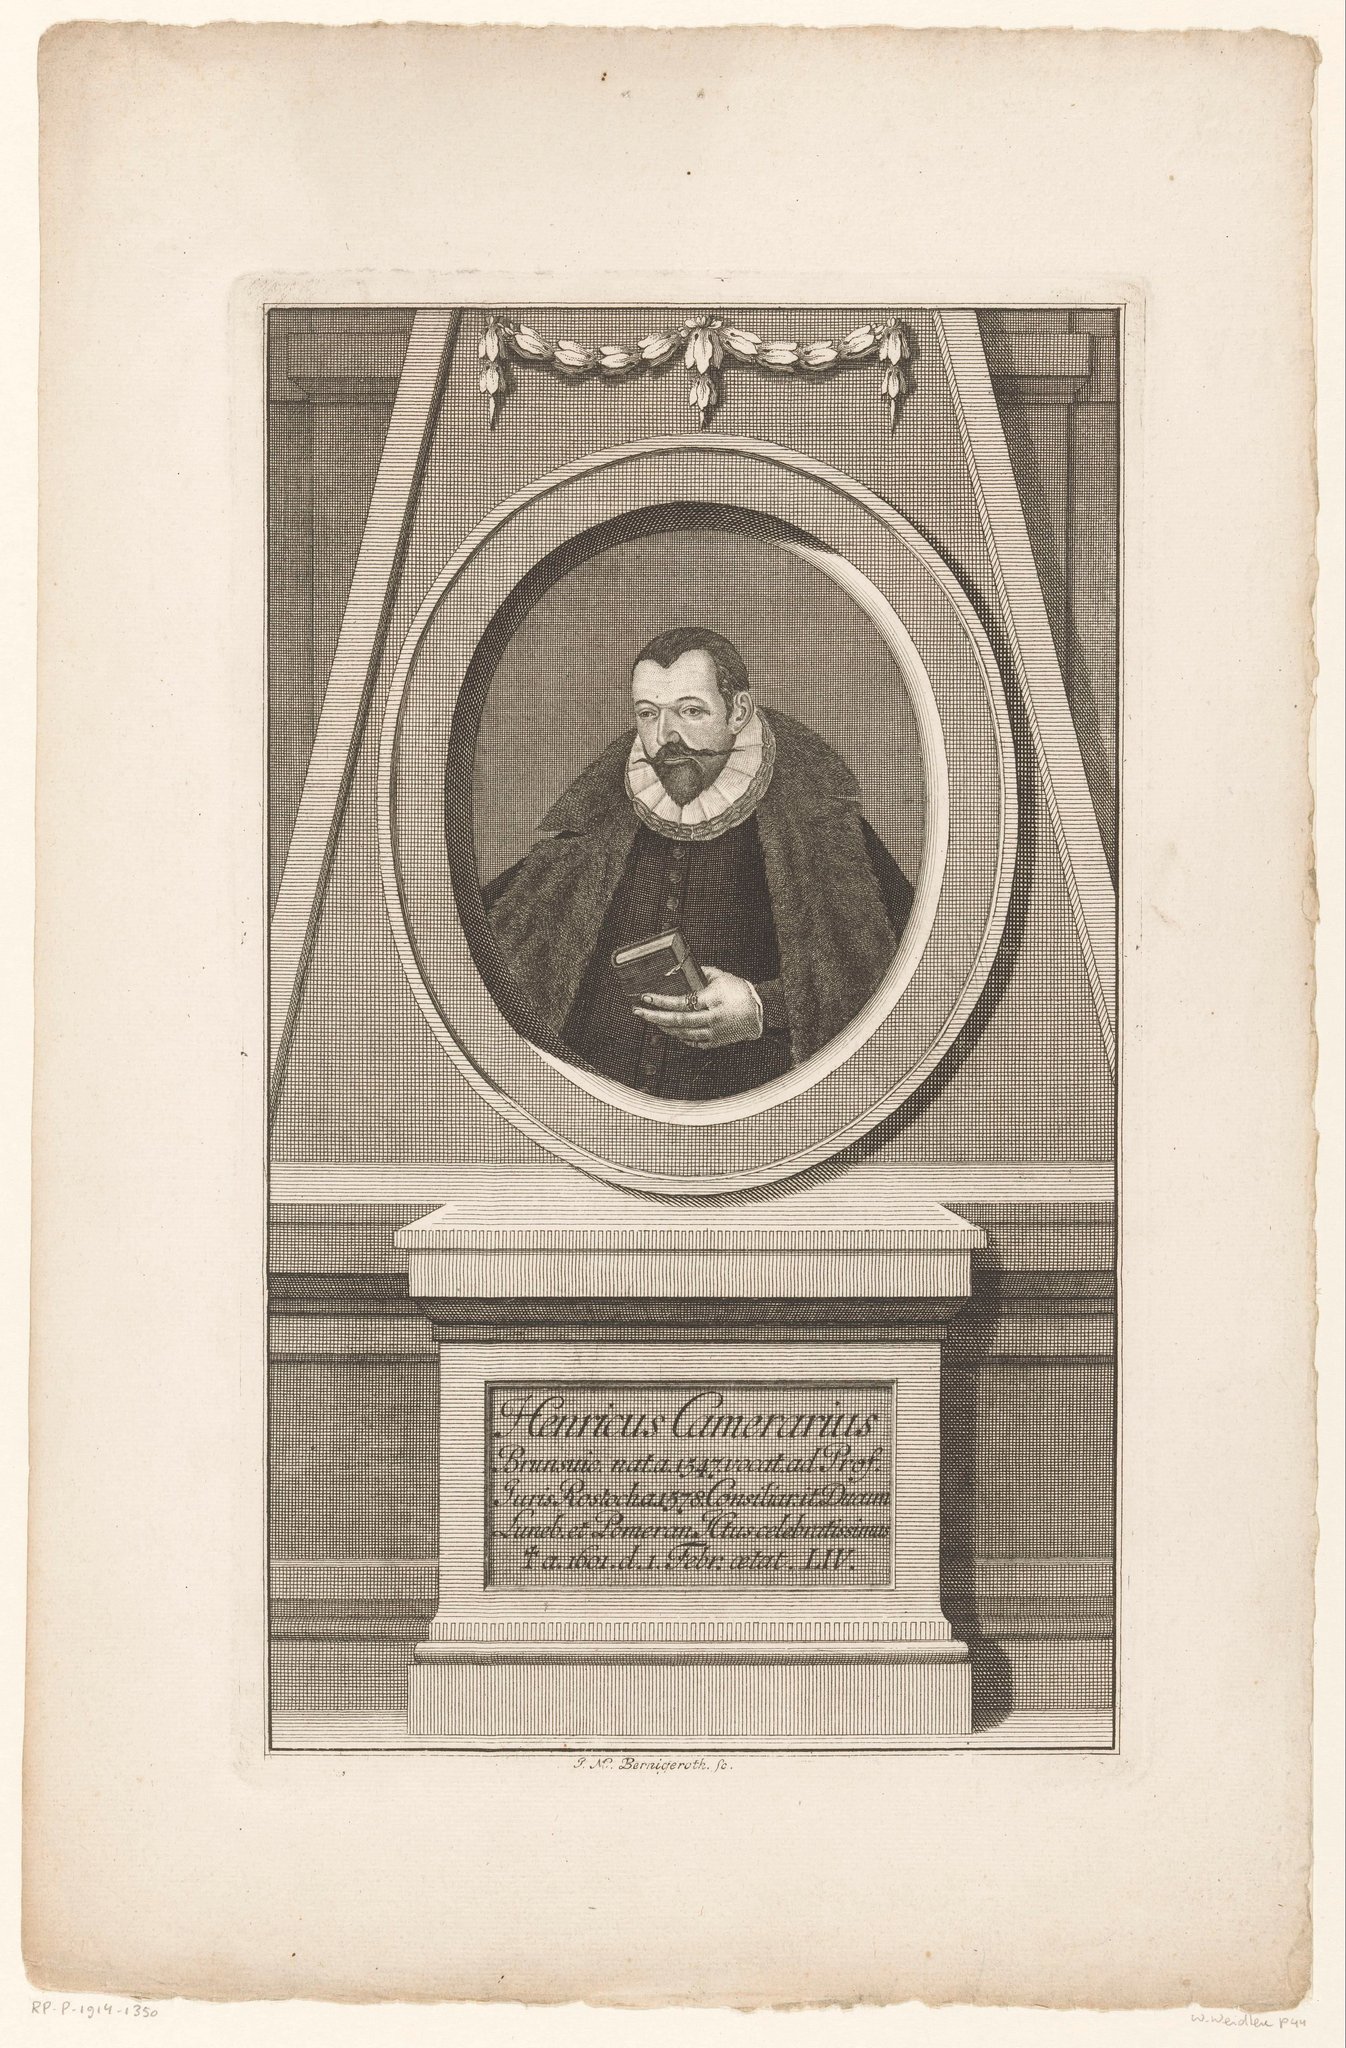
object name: print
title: Portret van Heinrich Camerarius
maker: johann martin bernigeroth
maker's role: print maker, publisher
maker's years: 1713-1767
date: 1743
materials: paper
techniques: engraving, etching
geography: leipzig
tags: historical persons, book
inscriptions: collector's mark: Lugt 2228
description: Een andere staat van deze prent is gebruikt in: Westphalen, Ernst Joachim von. Monumenta Inedita Rerum Germanicarum Praecipue Cimbricarum Et Megapolensium (...). 4 dln. Leipzig: Johann Christian Martini, 1739-1745, dl. 3 (1743), p. 1366.